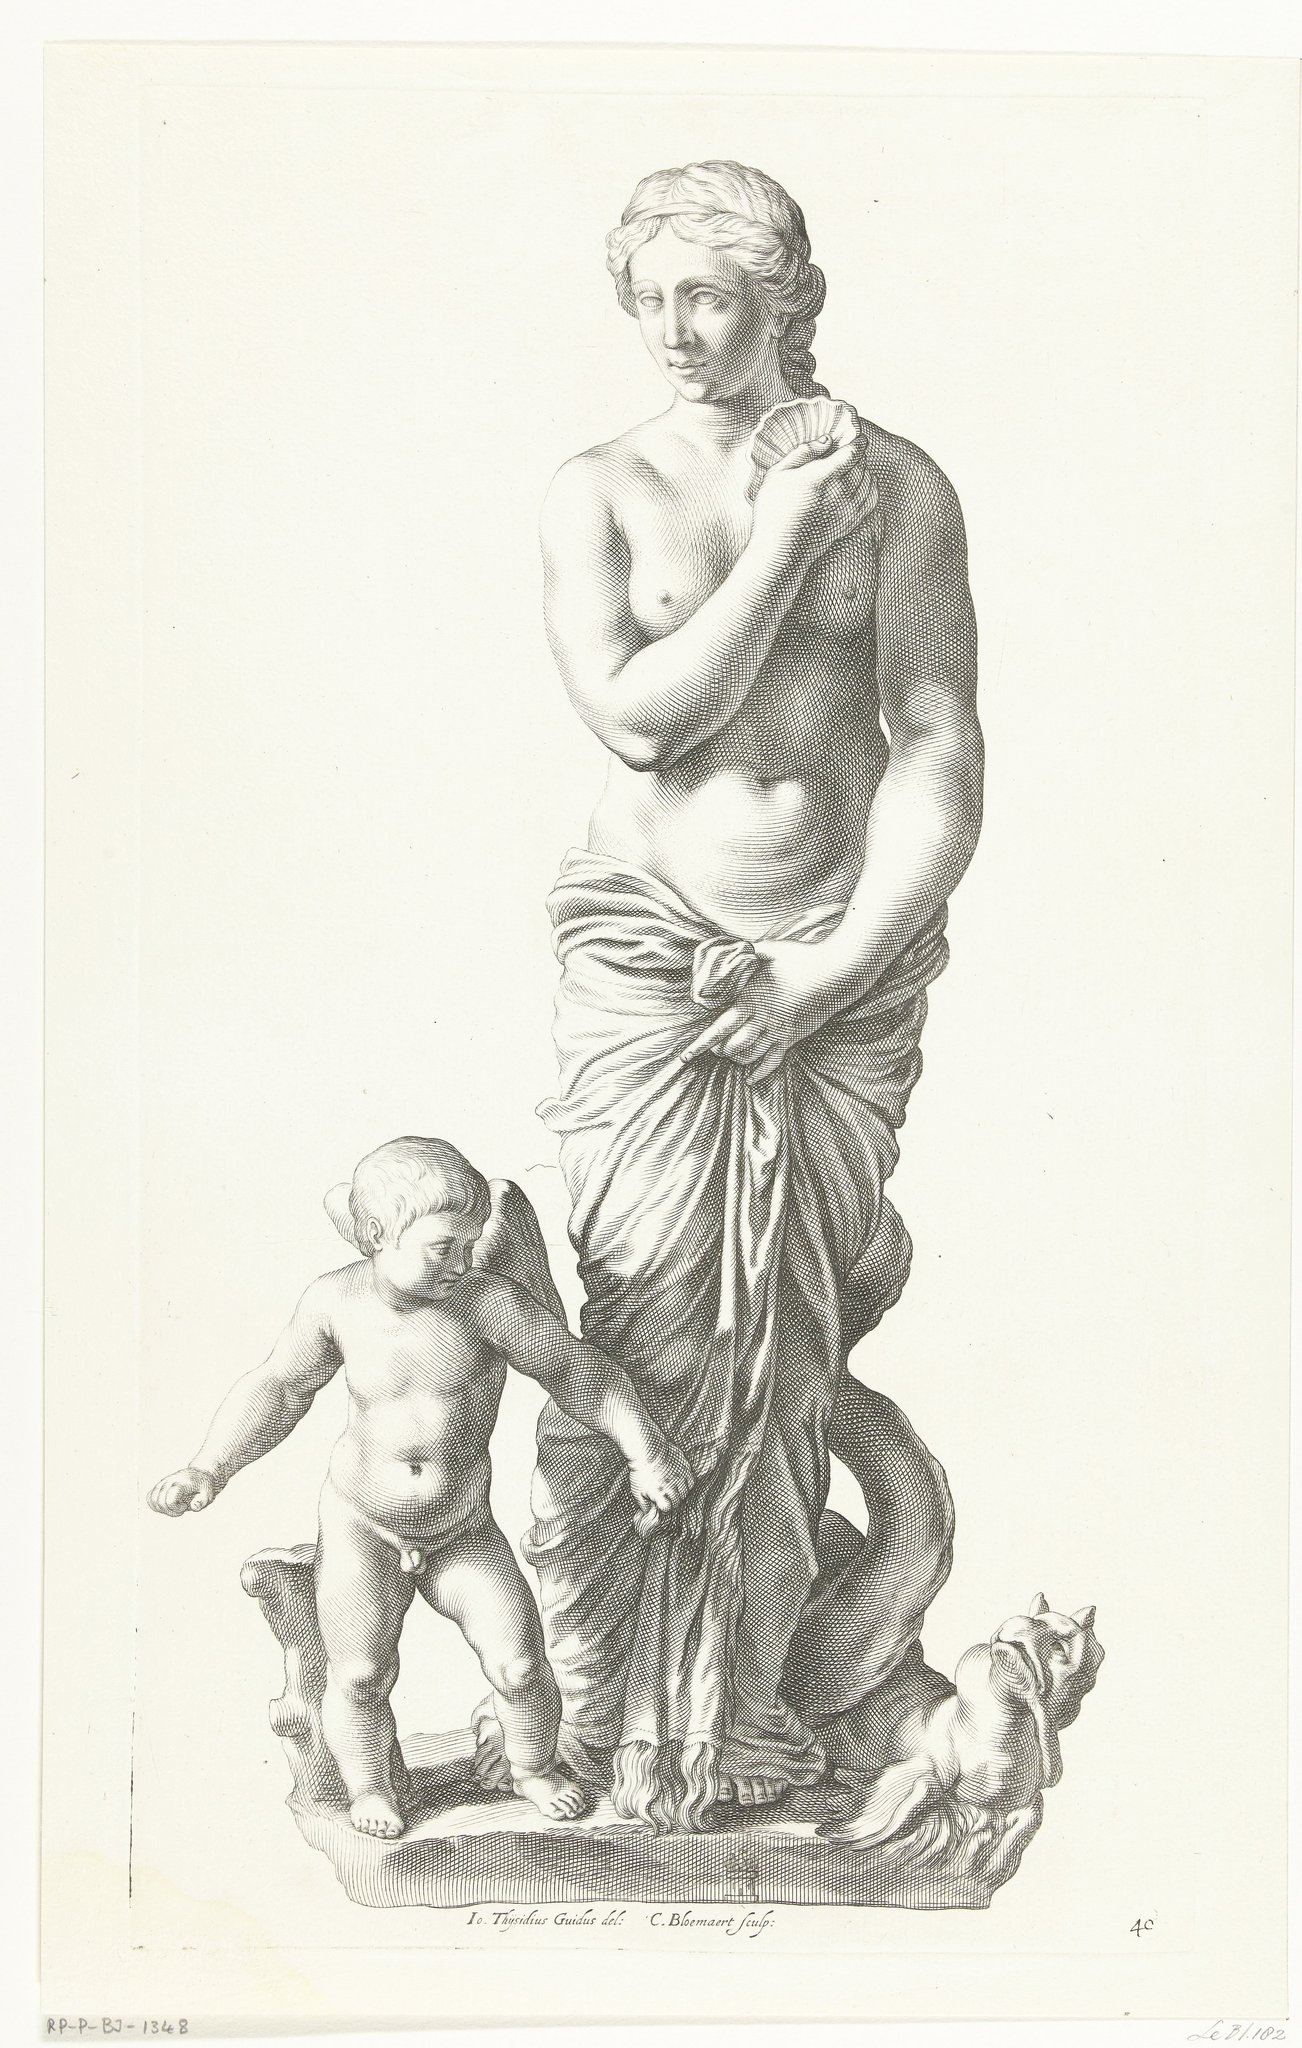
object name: print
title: Venus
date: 1636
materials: paper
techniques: engraving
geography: rome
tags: piece of sculpture, reproduction of a piece of sculpture, (story of) venus (aphrodite)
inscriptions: collector's mark: Lugt 2228, number: ‘40’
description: Beeld van Venus die in haar rechterhand een schelp vasthoudt. Rechts van haar trekt Amor aan haar kleed. Links aan haar voeten een zeemonster. Het beeld is afkomstig uit de collectie van Vincenzo Giustiniani, wiens wapen op de sokkel te zien is.